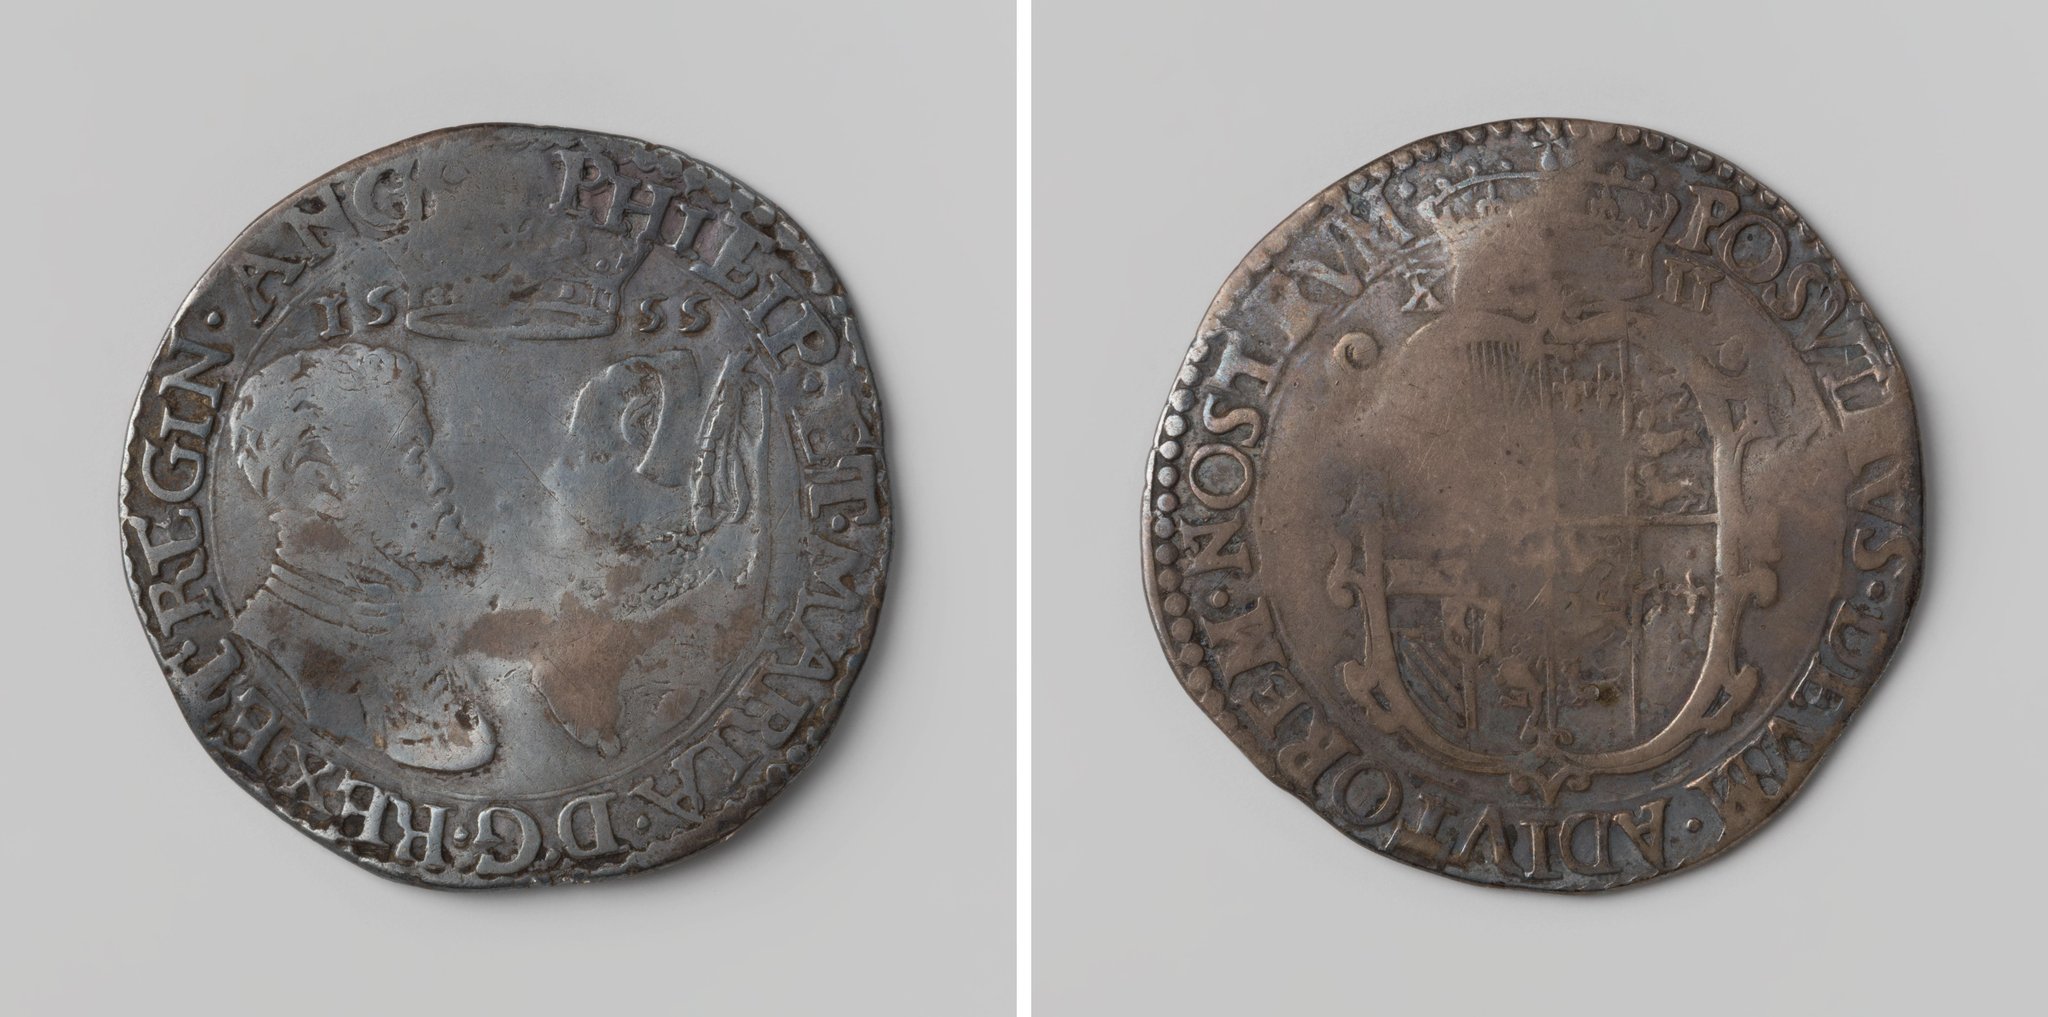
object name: jeton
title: Filips, erfprins van Spanje en Maria I, koningin van Engeland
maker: Anonymous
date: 1555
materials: silver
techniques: striking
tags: philip ii of spain, london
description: Zilveren penning. Voorzijde: naar elkaar gewende borststukken man en vrouw onder een kroon binnen omschrift. Keerzijde: gekroond wapenschild; links van kroon cijfer X, rechts twee cijfers I binnen omschrift